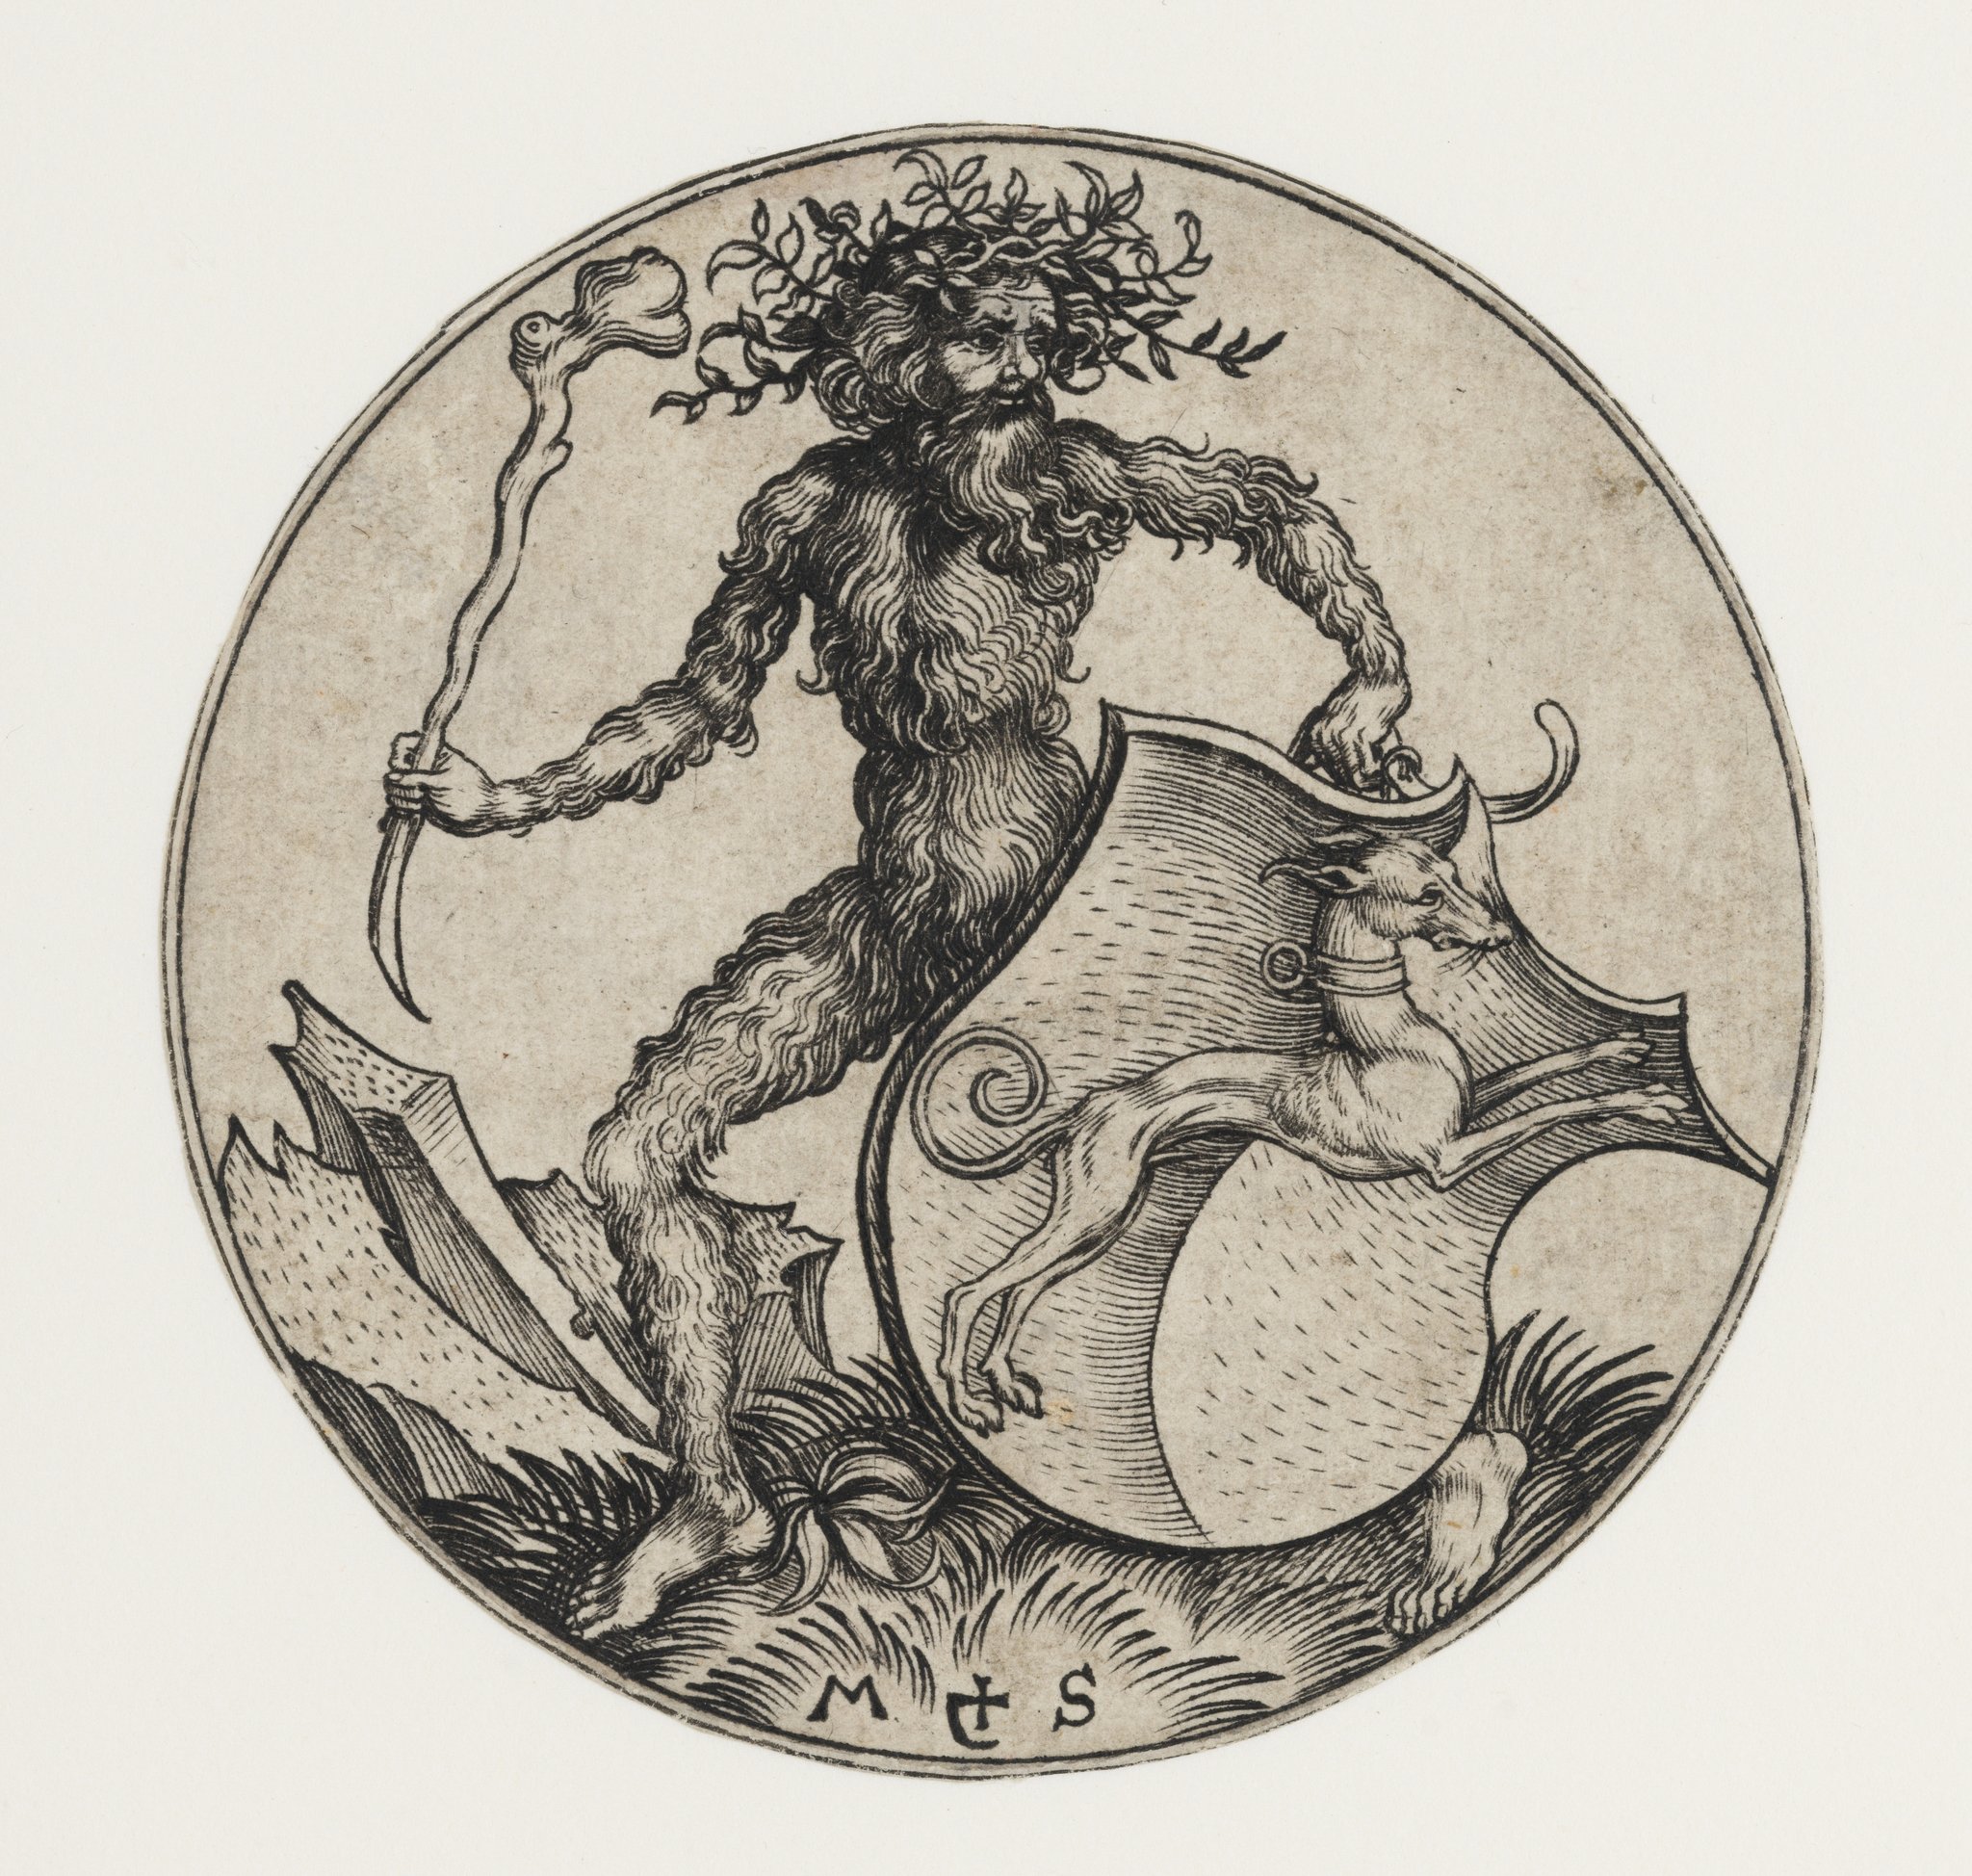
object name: print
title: Shield with Greyhound Held by Wild Man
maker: martin schongauer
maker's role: artist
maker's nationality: german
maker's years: 1430-1491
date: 1470-1491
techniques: engraving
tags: shields,men,dogs